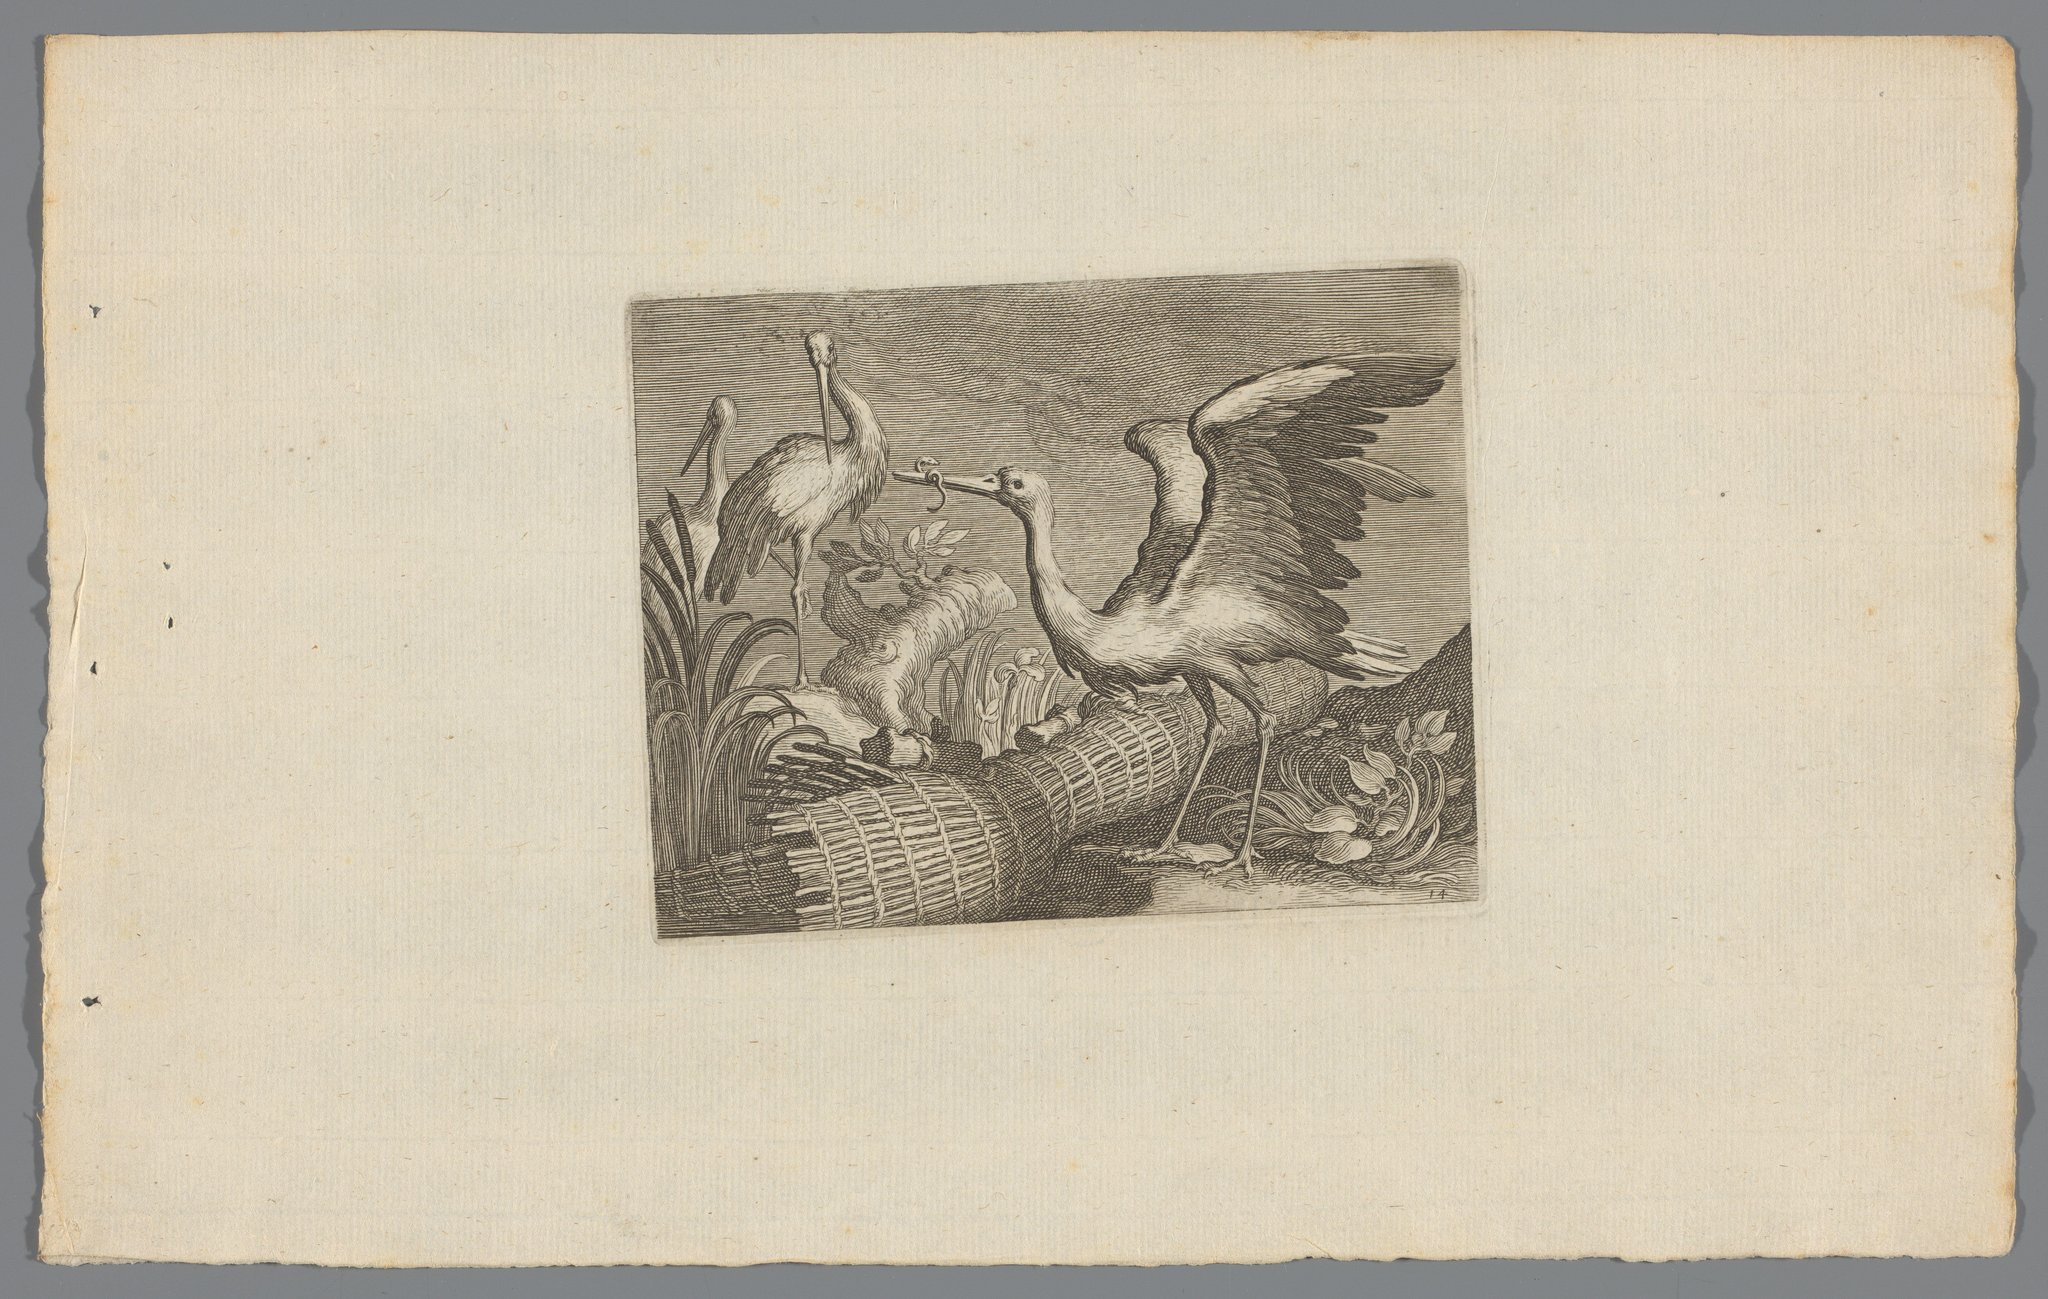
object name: print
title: Ooievaars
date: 1611-1632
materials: paper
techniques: engraving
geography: amsterdam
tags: shore-birds and wading-birds: stork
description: Prent maakt deel uit van een serie van veertien prenten.